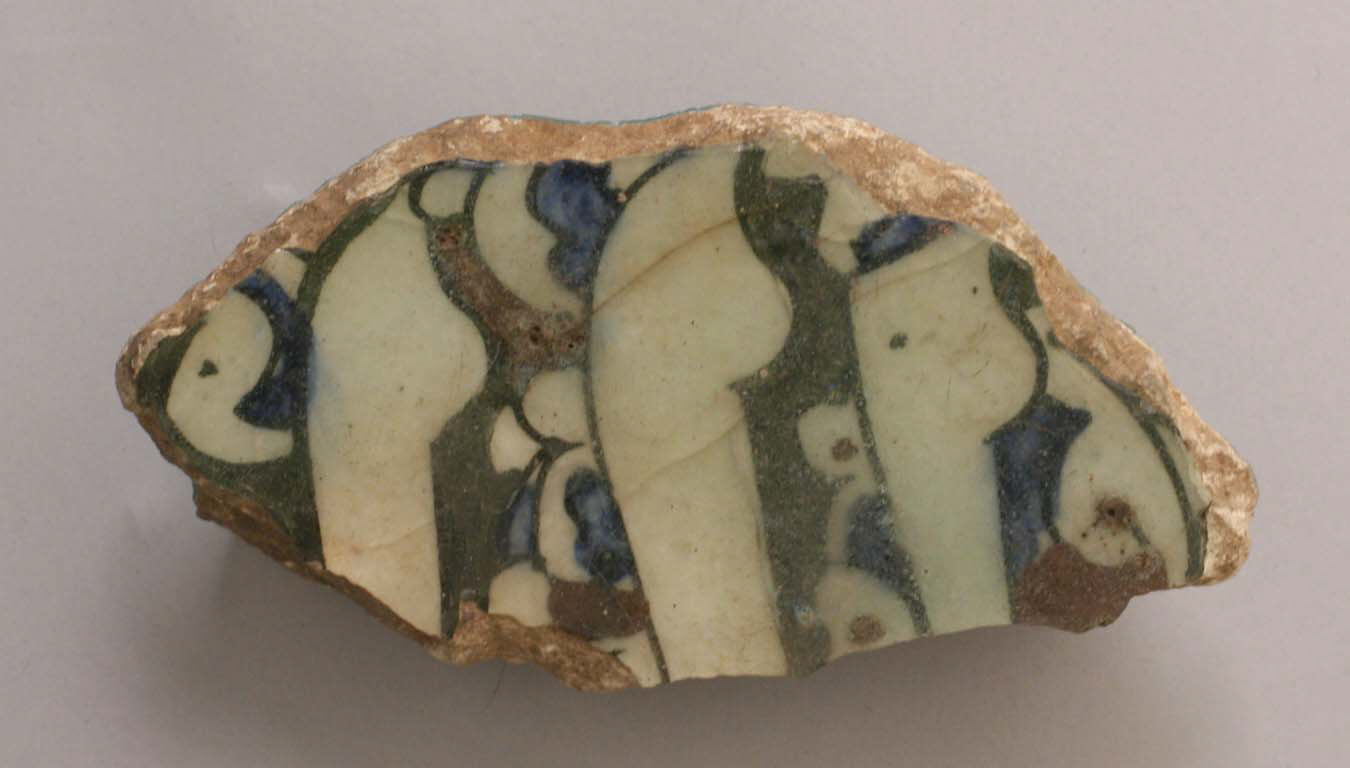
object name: fragment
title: Ceramic Fragment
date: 1201-1300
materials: stonepaste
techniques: painting, polychrome, underglaze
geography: syria